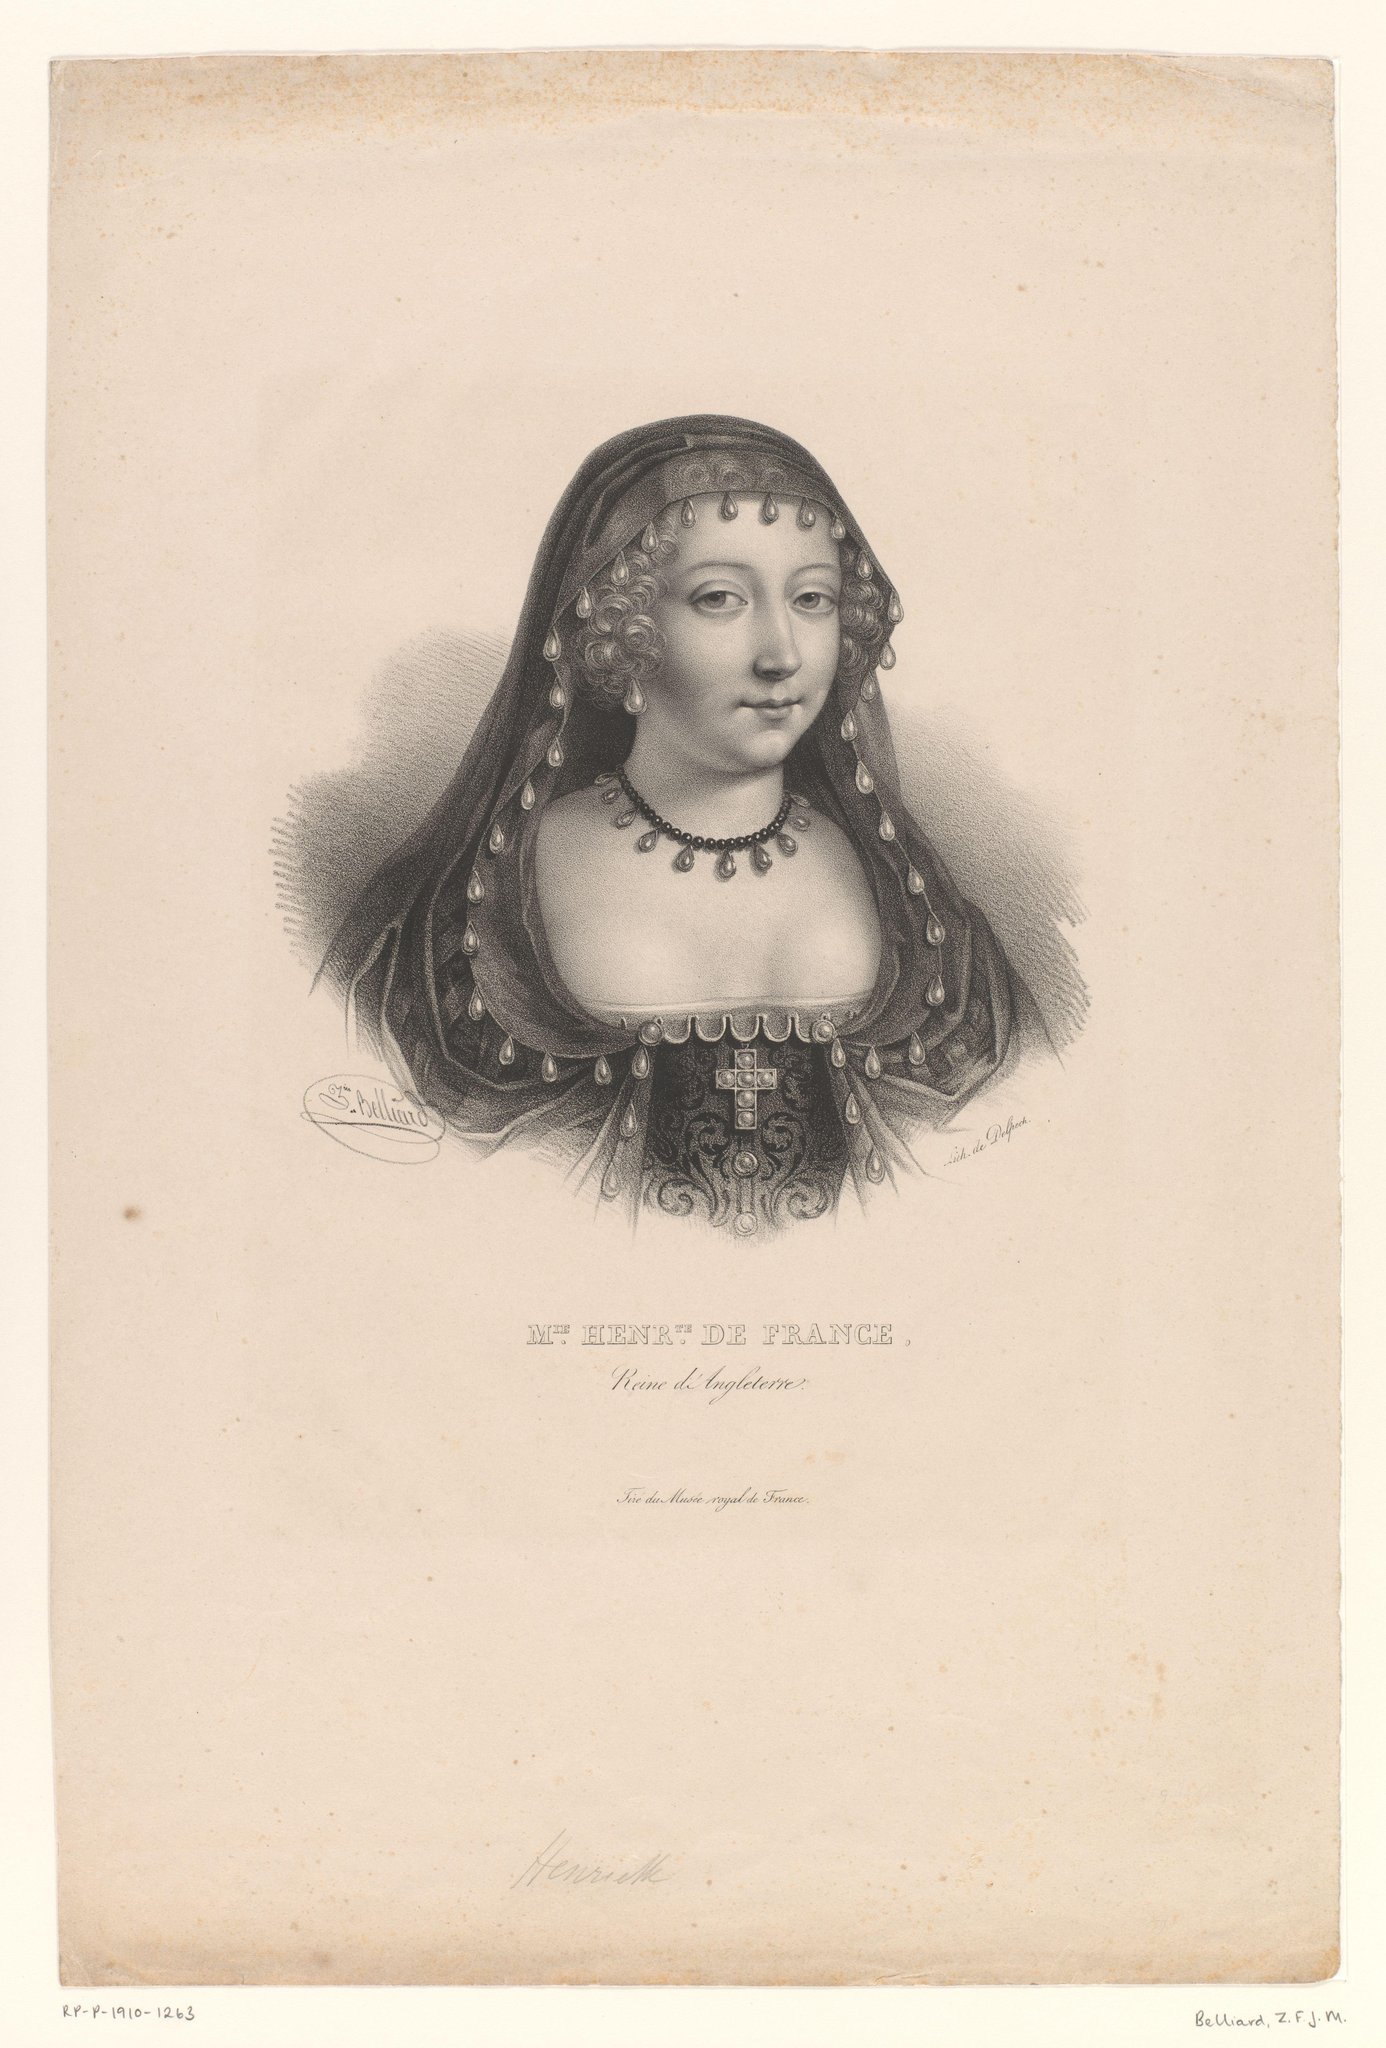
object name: book illustration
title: Portret van Henriëtta Maria van Frankrijk, koningin van Engeland, Schotland en Ierland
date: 1832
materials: paper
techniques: lithograph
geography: paris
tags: henriëtta maria van frankrijk (koningin van engeland, schotland en ierland), historical persons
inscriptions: collector's mark: Lugt 2228a